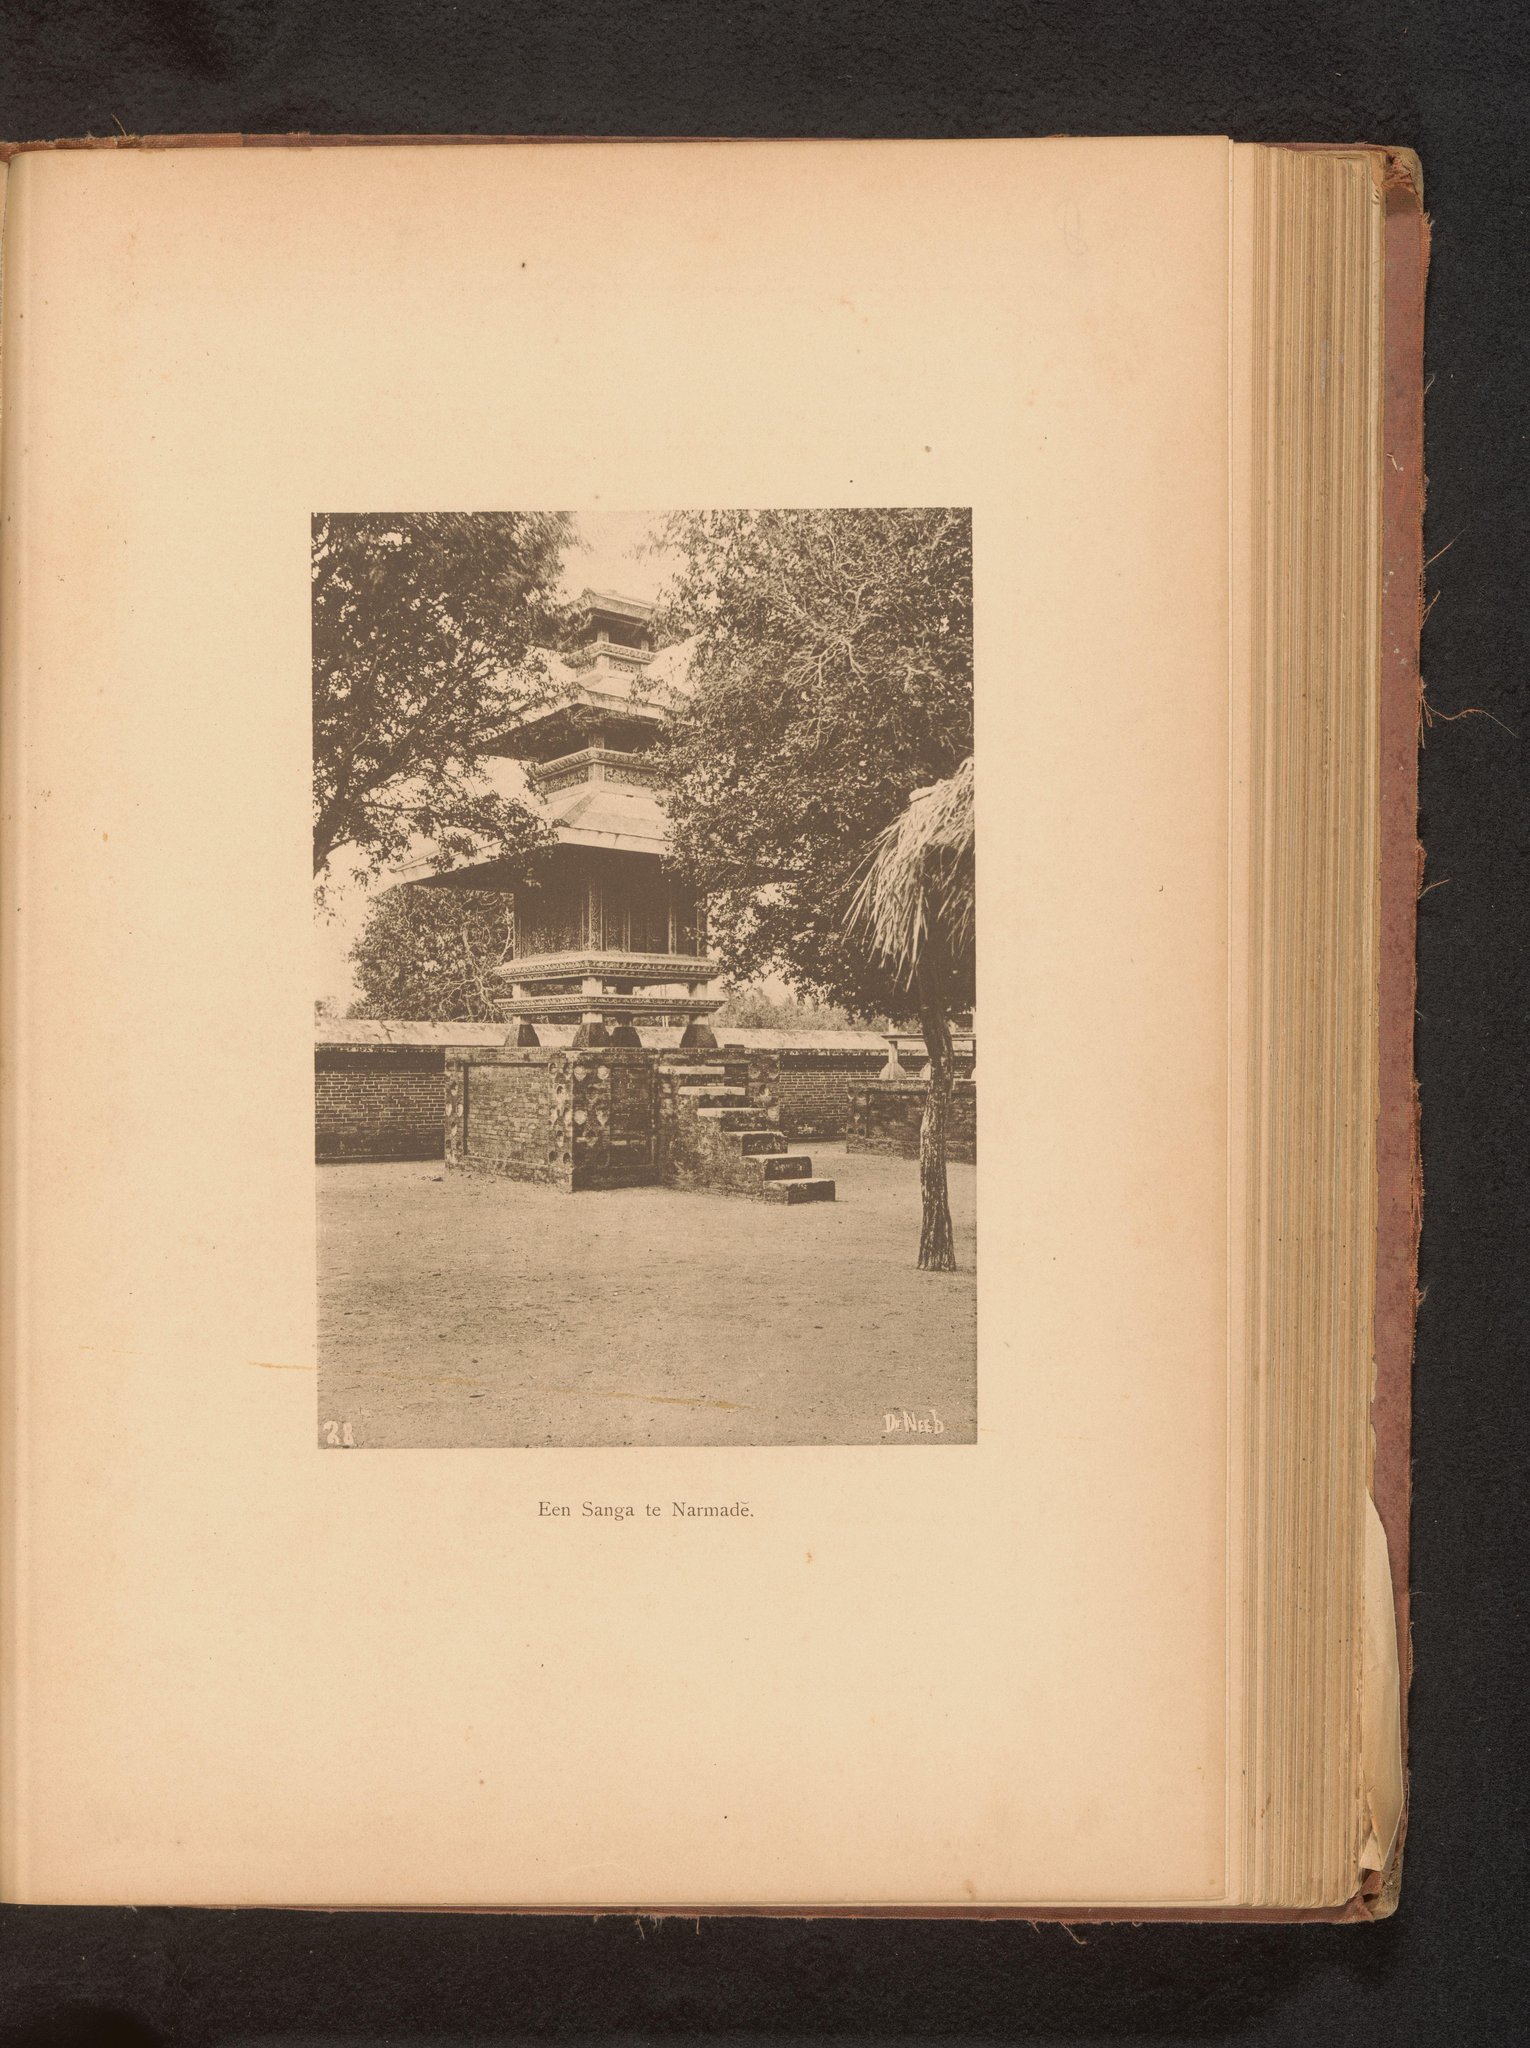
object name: page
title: Een Sanga te Narmade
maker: christiaan johan neeb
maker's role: arts, fotograaf, officier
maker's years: 1860-1925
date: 1892-1897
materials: paper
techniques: photograph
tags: landscapes, temple, shrine ~ non-christian religions